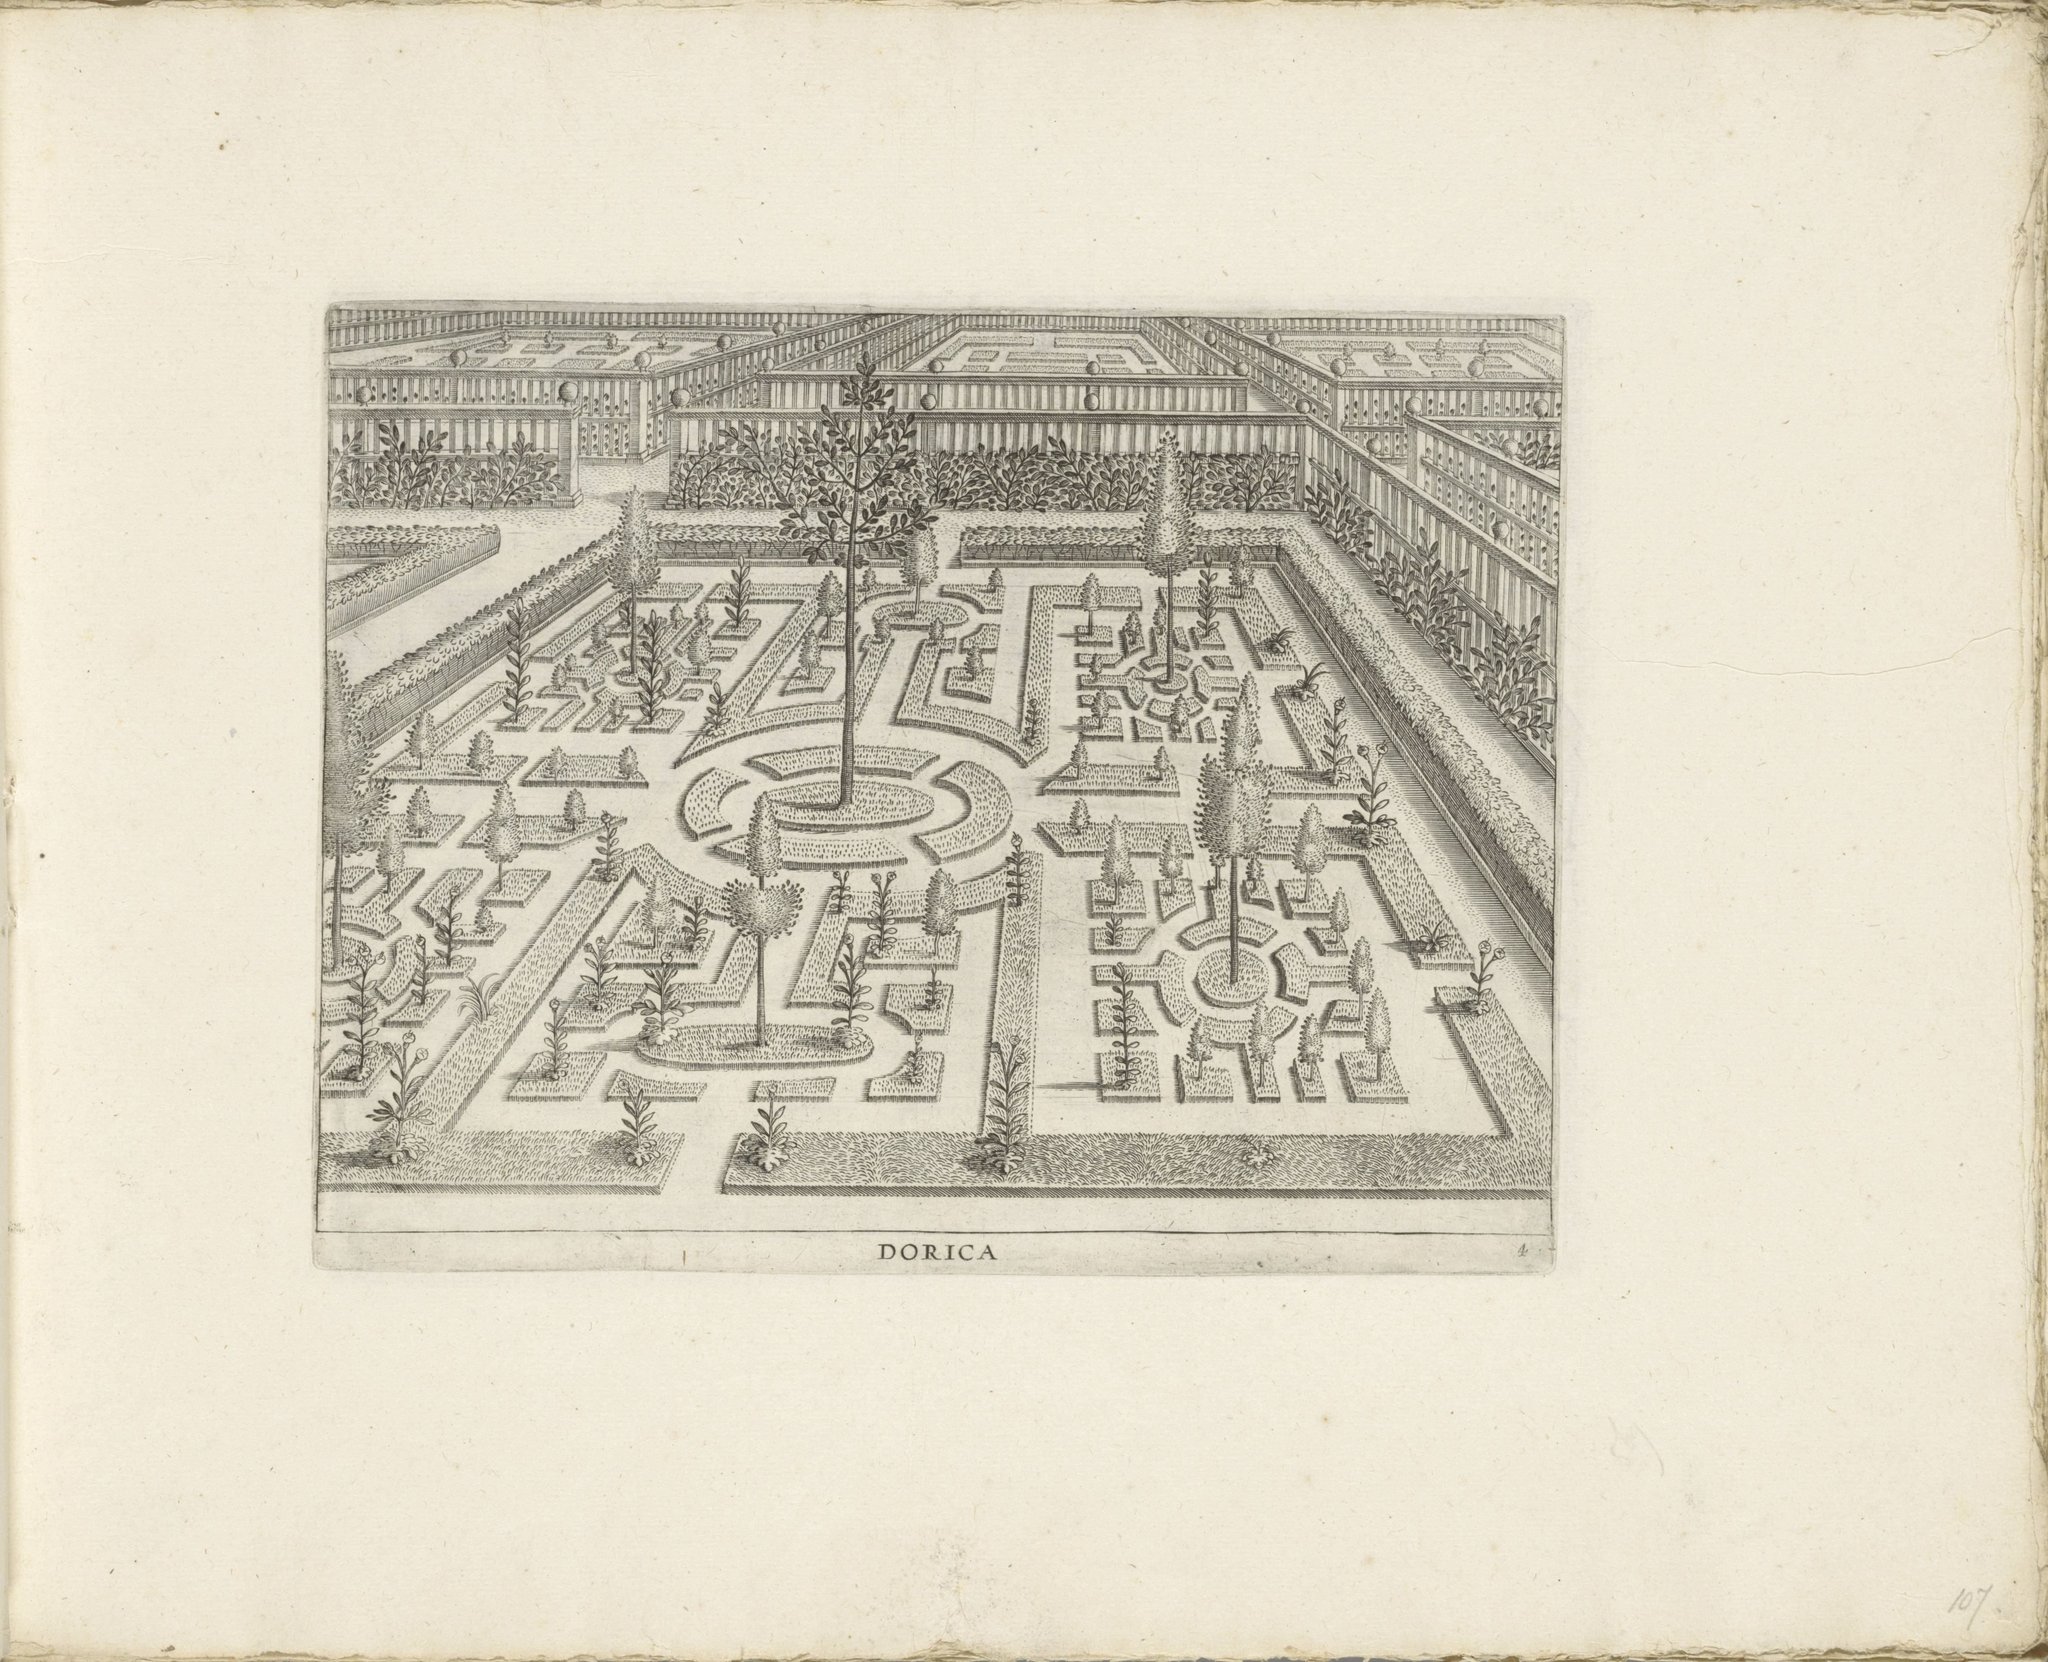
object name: print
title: Tuinontwerpen geassocieerd met de Dorische, Ionische en Korinthische bouworden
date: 1583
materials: paper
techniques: etching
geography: antwerp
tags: garden, french or architectonic garden; formal garden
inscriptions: collector's mark: Lugt 2228, collector's mark: Lugt 2760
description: De serie ‘Hortorum Viridariorumque’ van Vredeman de Vries (Hollstein Dutch 470-490) is in deze editie van de serie door uitgever Joannes Galle ( en eerder door zijn voorganger Theodoor Galle) aangevuld met de serie ‘Tuinen’ van Vredeman de Vries (Hollstein Dutch 508-515) en met twee prenten van Pieter van der Borcht (I) (New Hollstein Dutch 161-162). De prenten zijn genummerd: 1-30. Origineel hoort bij deze editie van de serie, uitgegeven door Joannes Galle, nog een prent van Van der Borcht met nummer 31, maar deze prent ontbreekt in deze serie in de collectie van het Rijksmuseum.